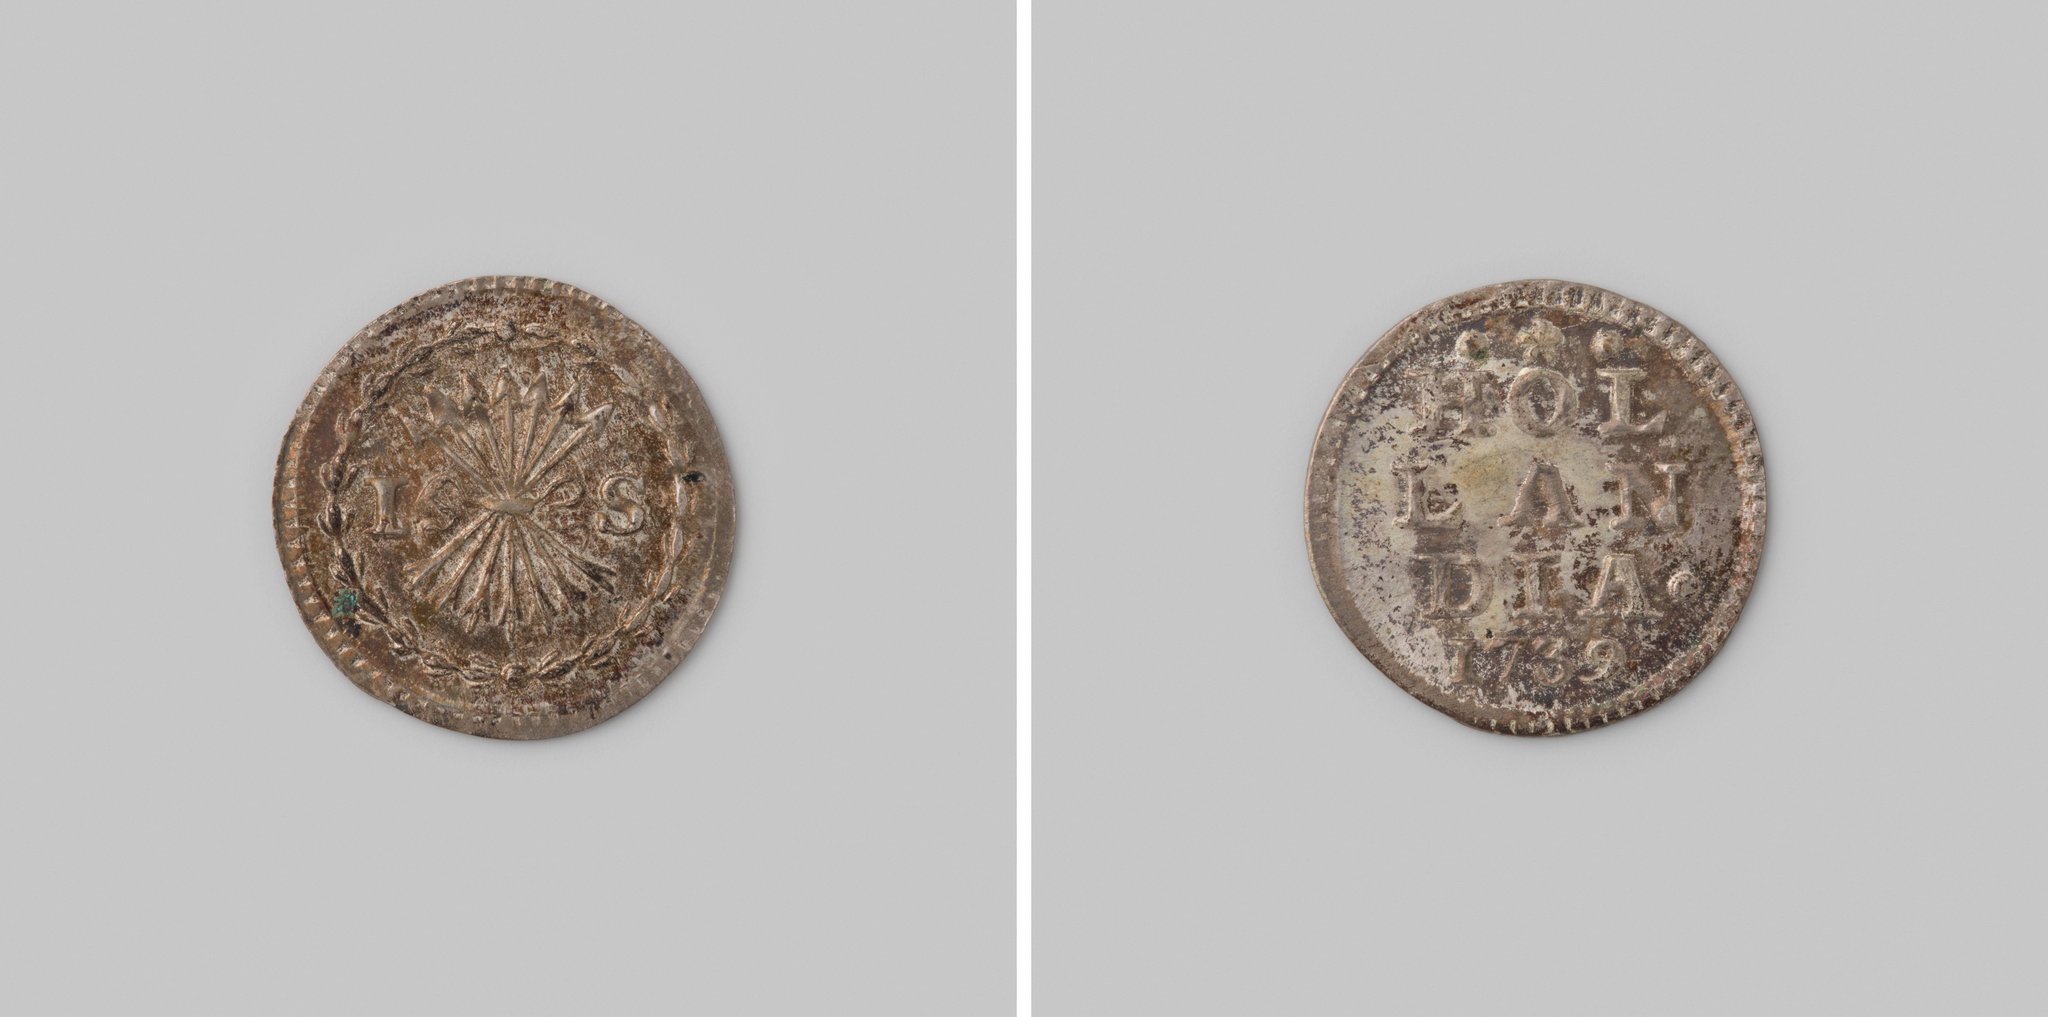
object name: coin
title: Holland, stuiver, 1739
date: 1739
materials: silver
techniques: striking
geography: dordrecht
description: Zilveren munt. Voorzijde: binnen krans tussen waarde-aanduiding pijlenbundel. Keerzijde: opschrift: provincienaam in drie regels, daaronder jaartal.